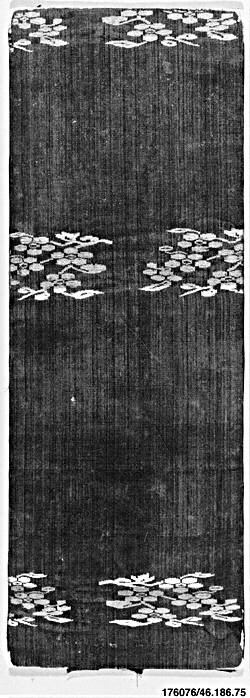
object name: sutra cover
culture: chinese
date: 1601-1700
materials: silk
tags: flowers